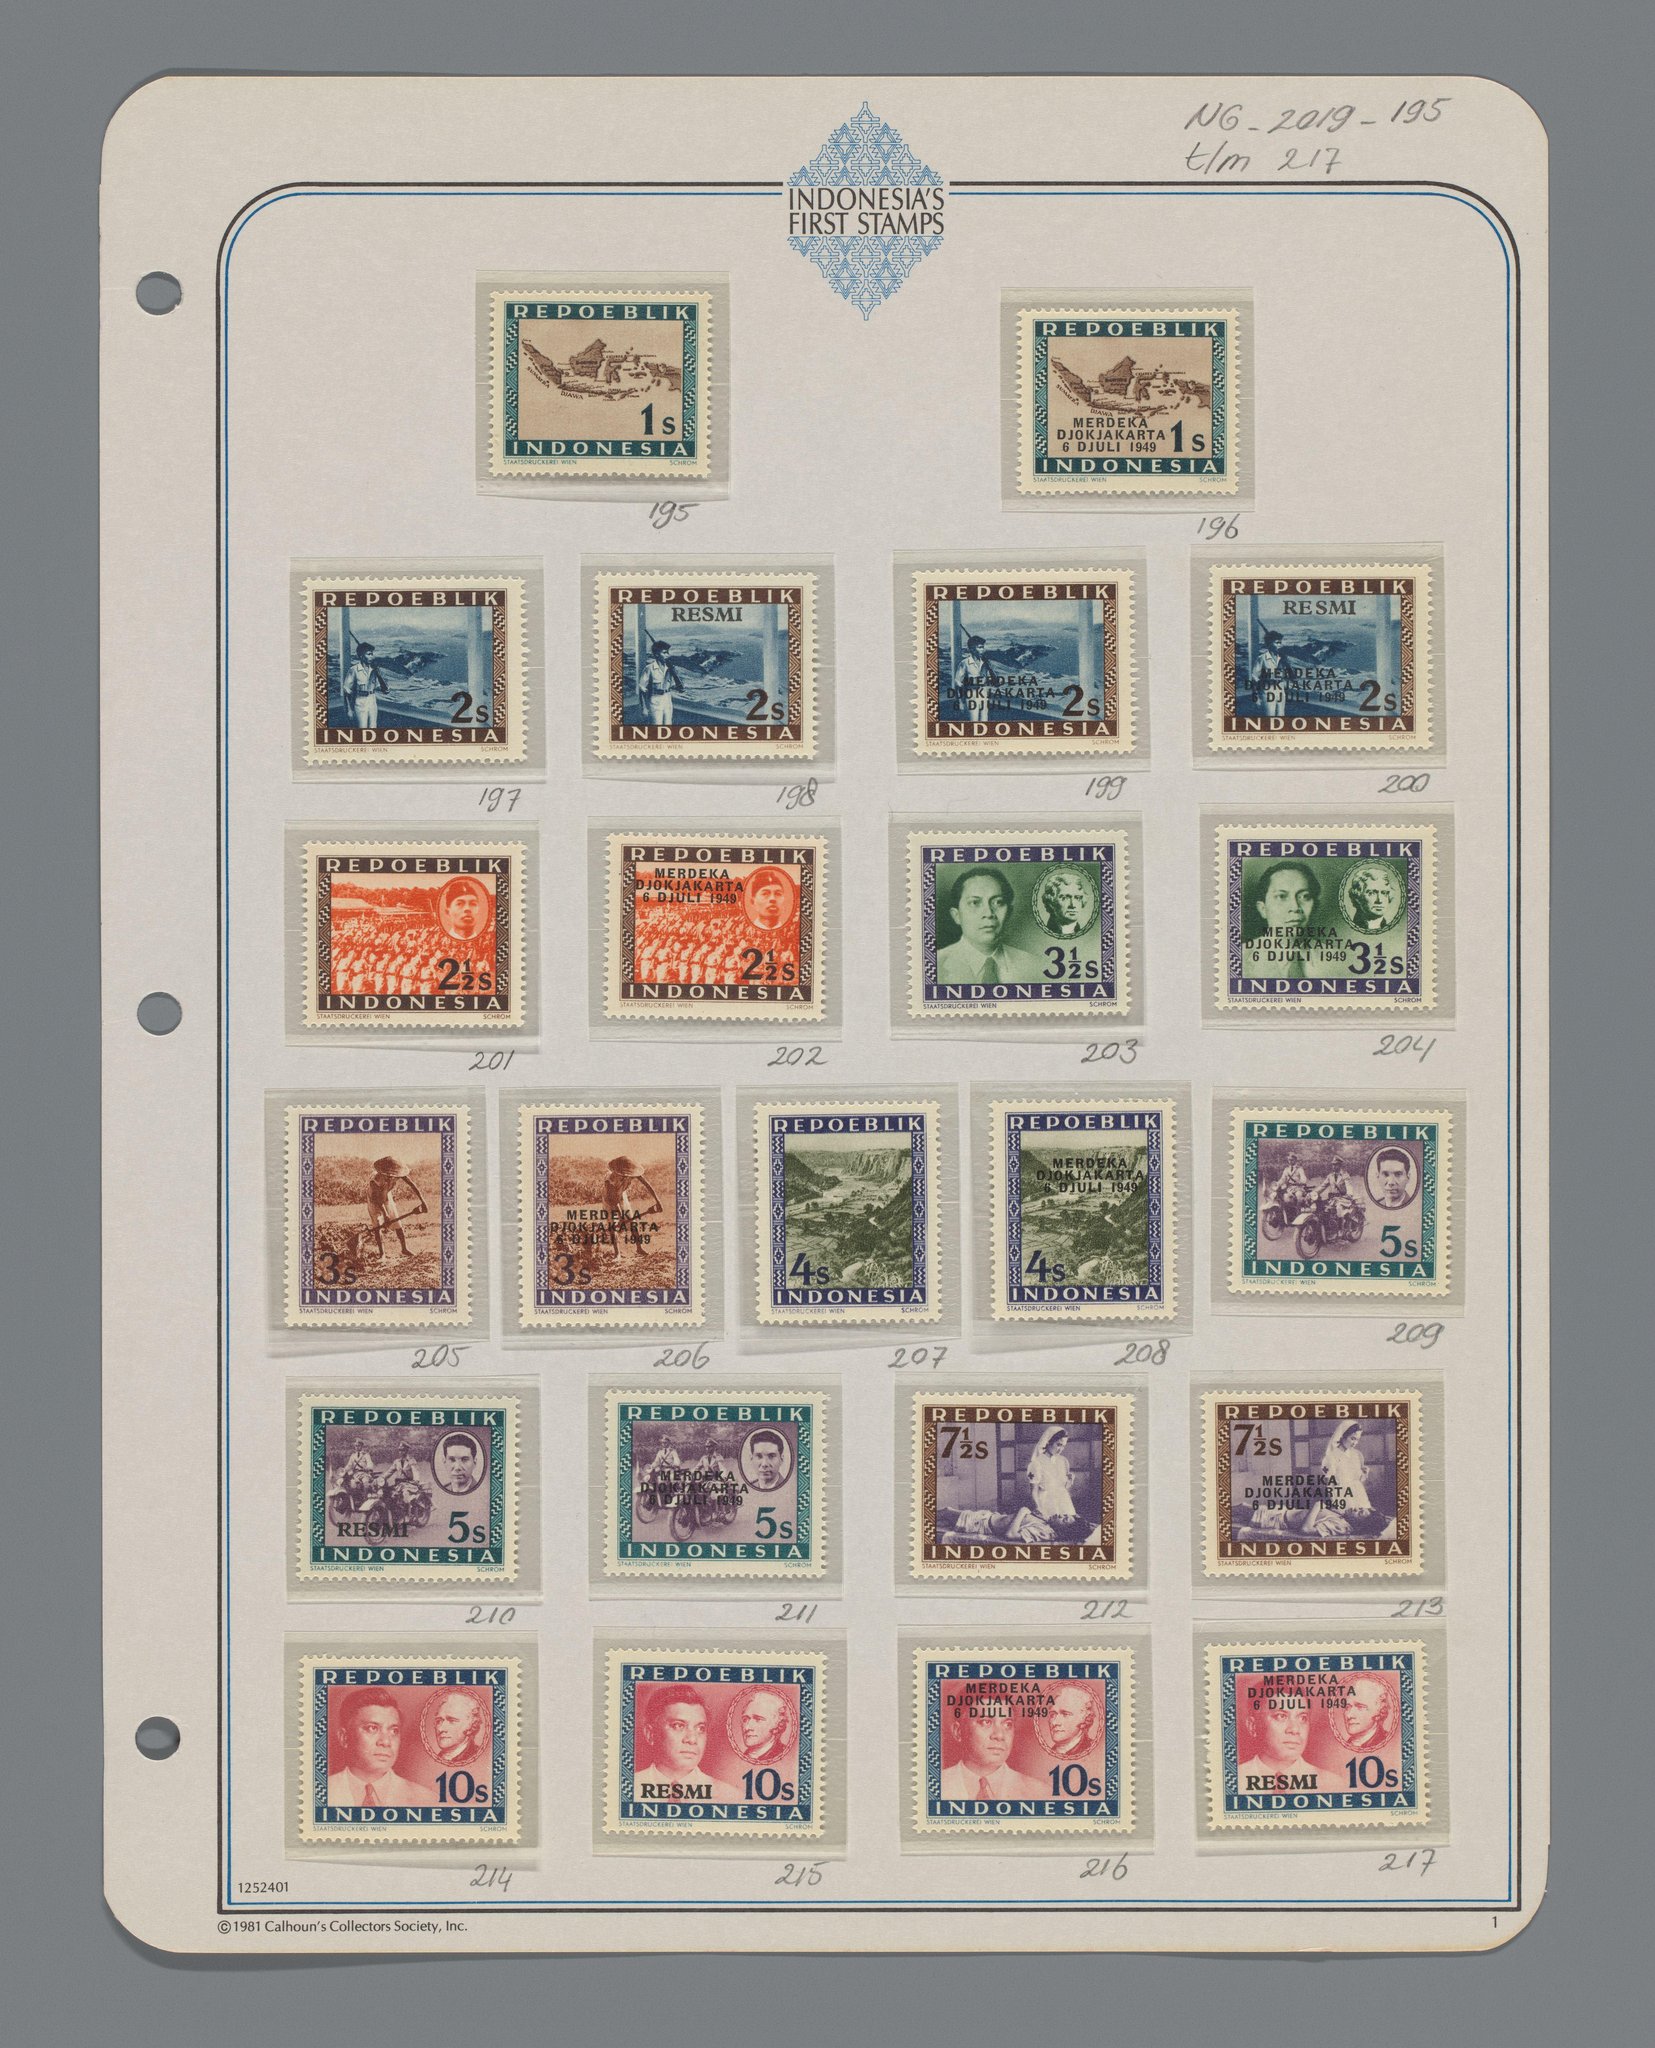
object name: postage stamp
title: Postzegel Republik Indonesia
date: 1949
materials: paper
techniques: photoaquatint, engraving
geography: philadelphia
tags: indonesia